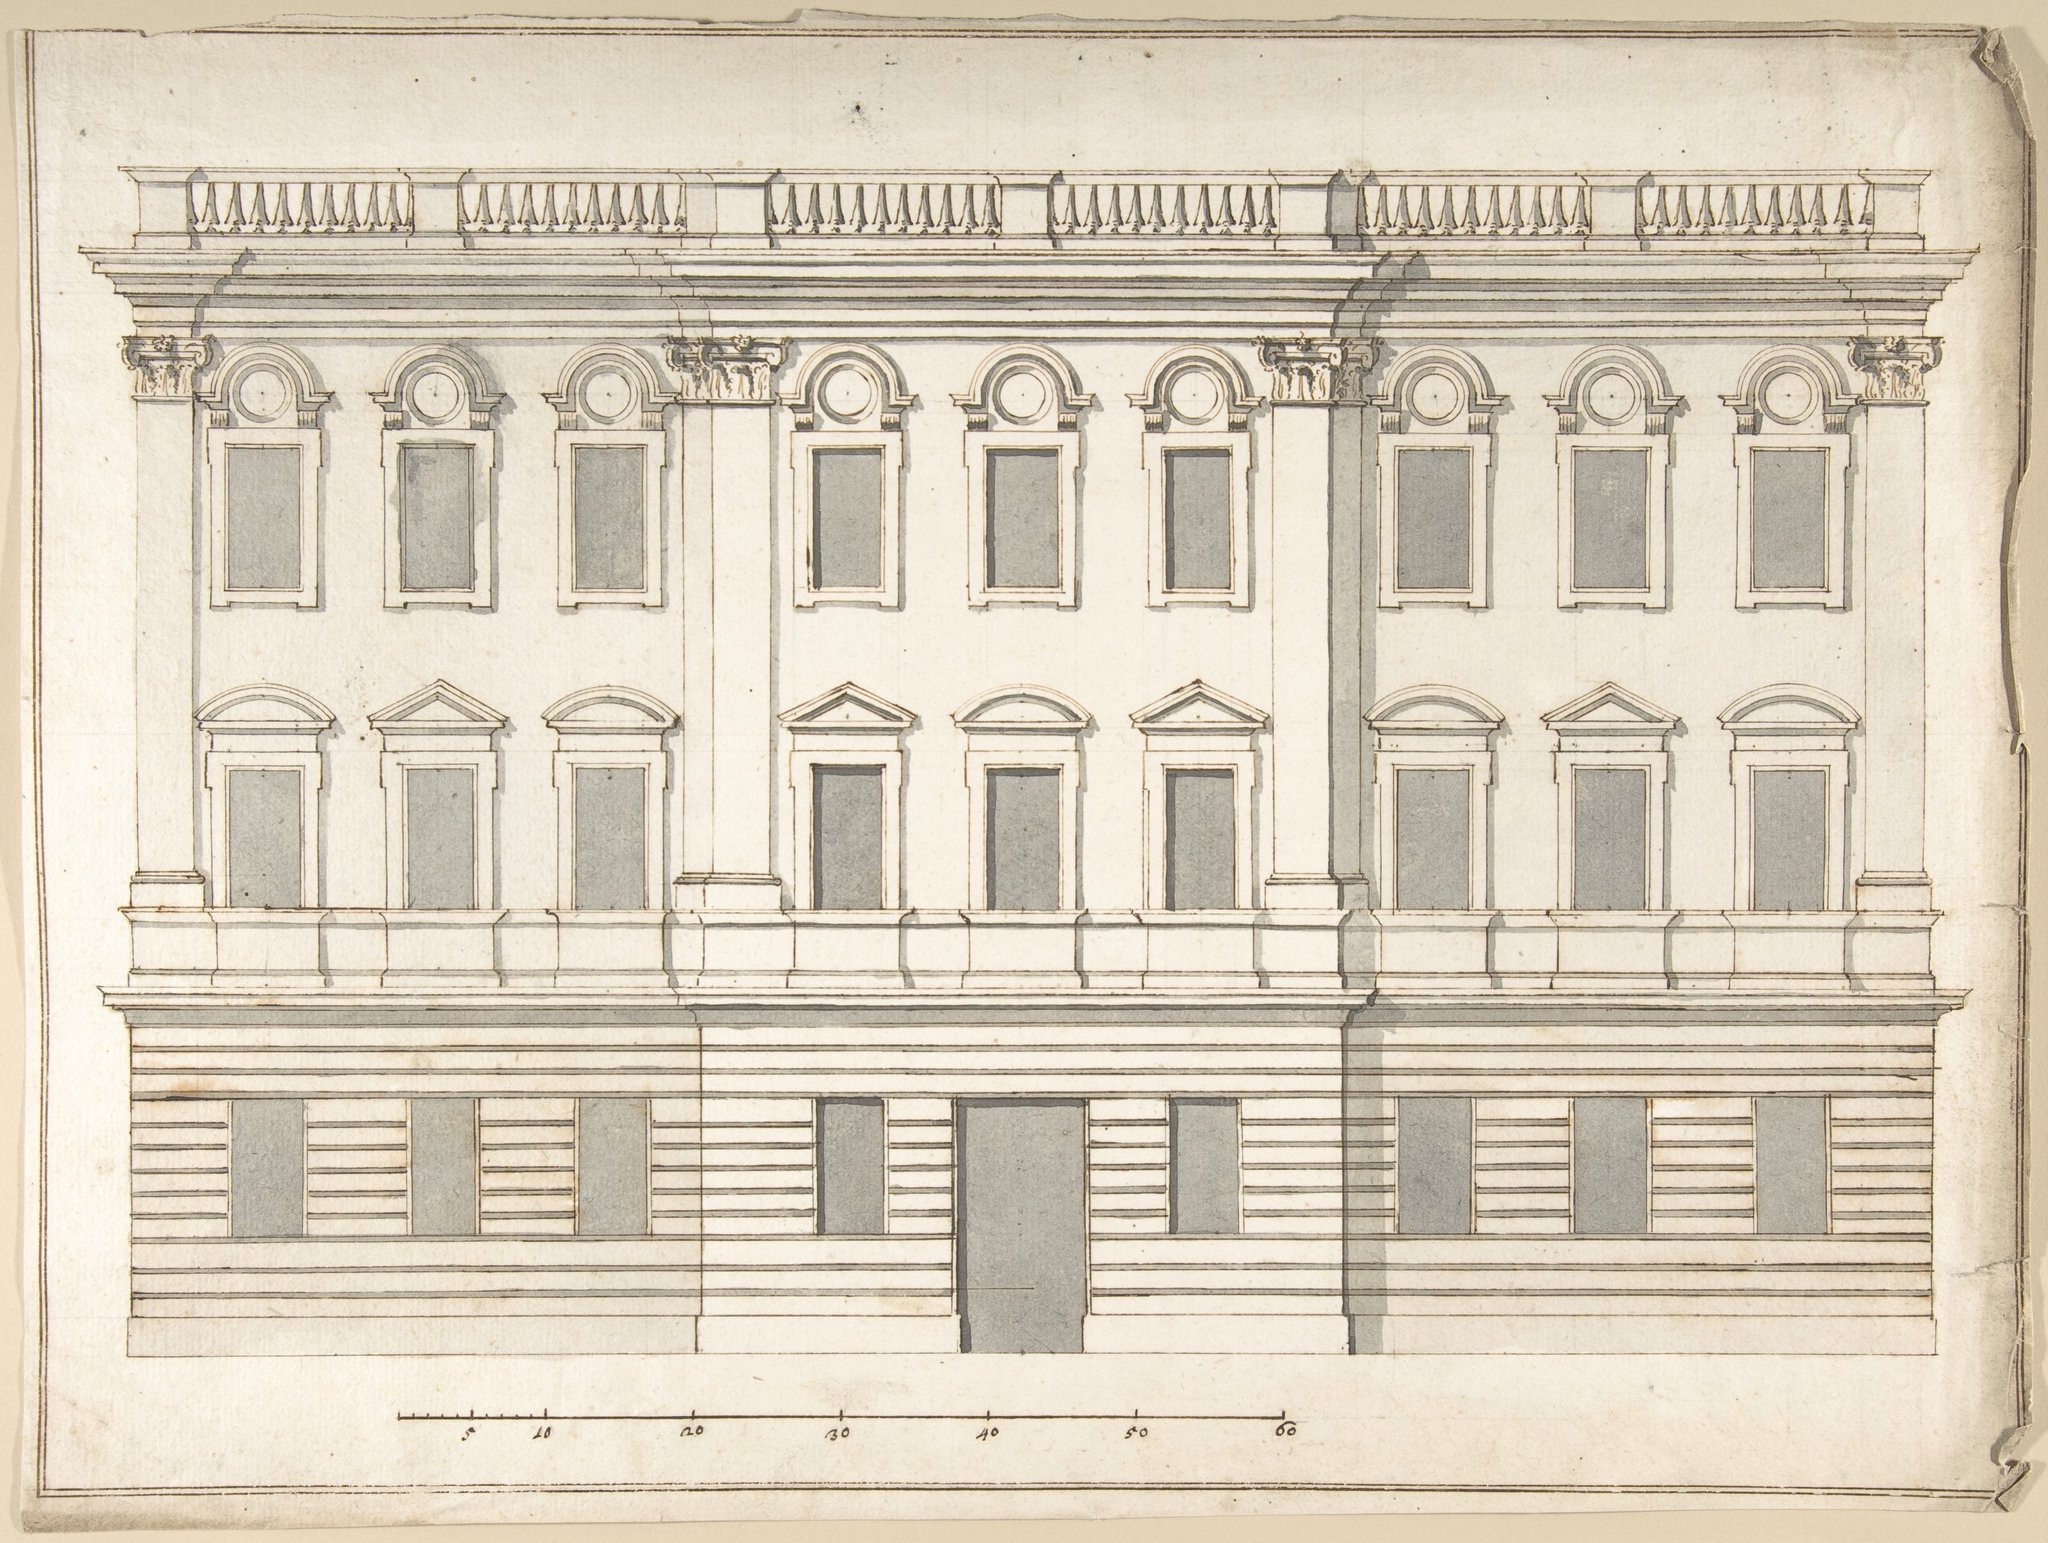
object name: drawing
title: Design for Palace Façade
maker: pietro paolo coccetti (cocchetti)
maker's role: artist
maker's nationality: italian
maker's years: 1710-1727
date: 1710-1727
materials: graphite, ink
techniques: brush, pen, wash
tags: architecture,palaces